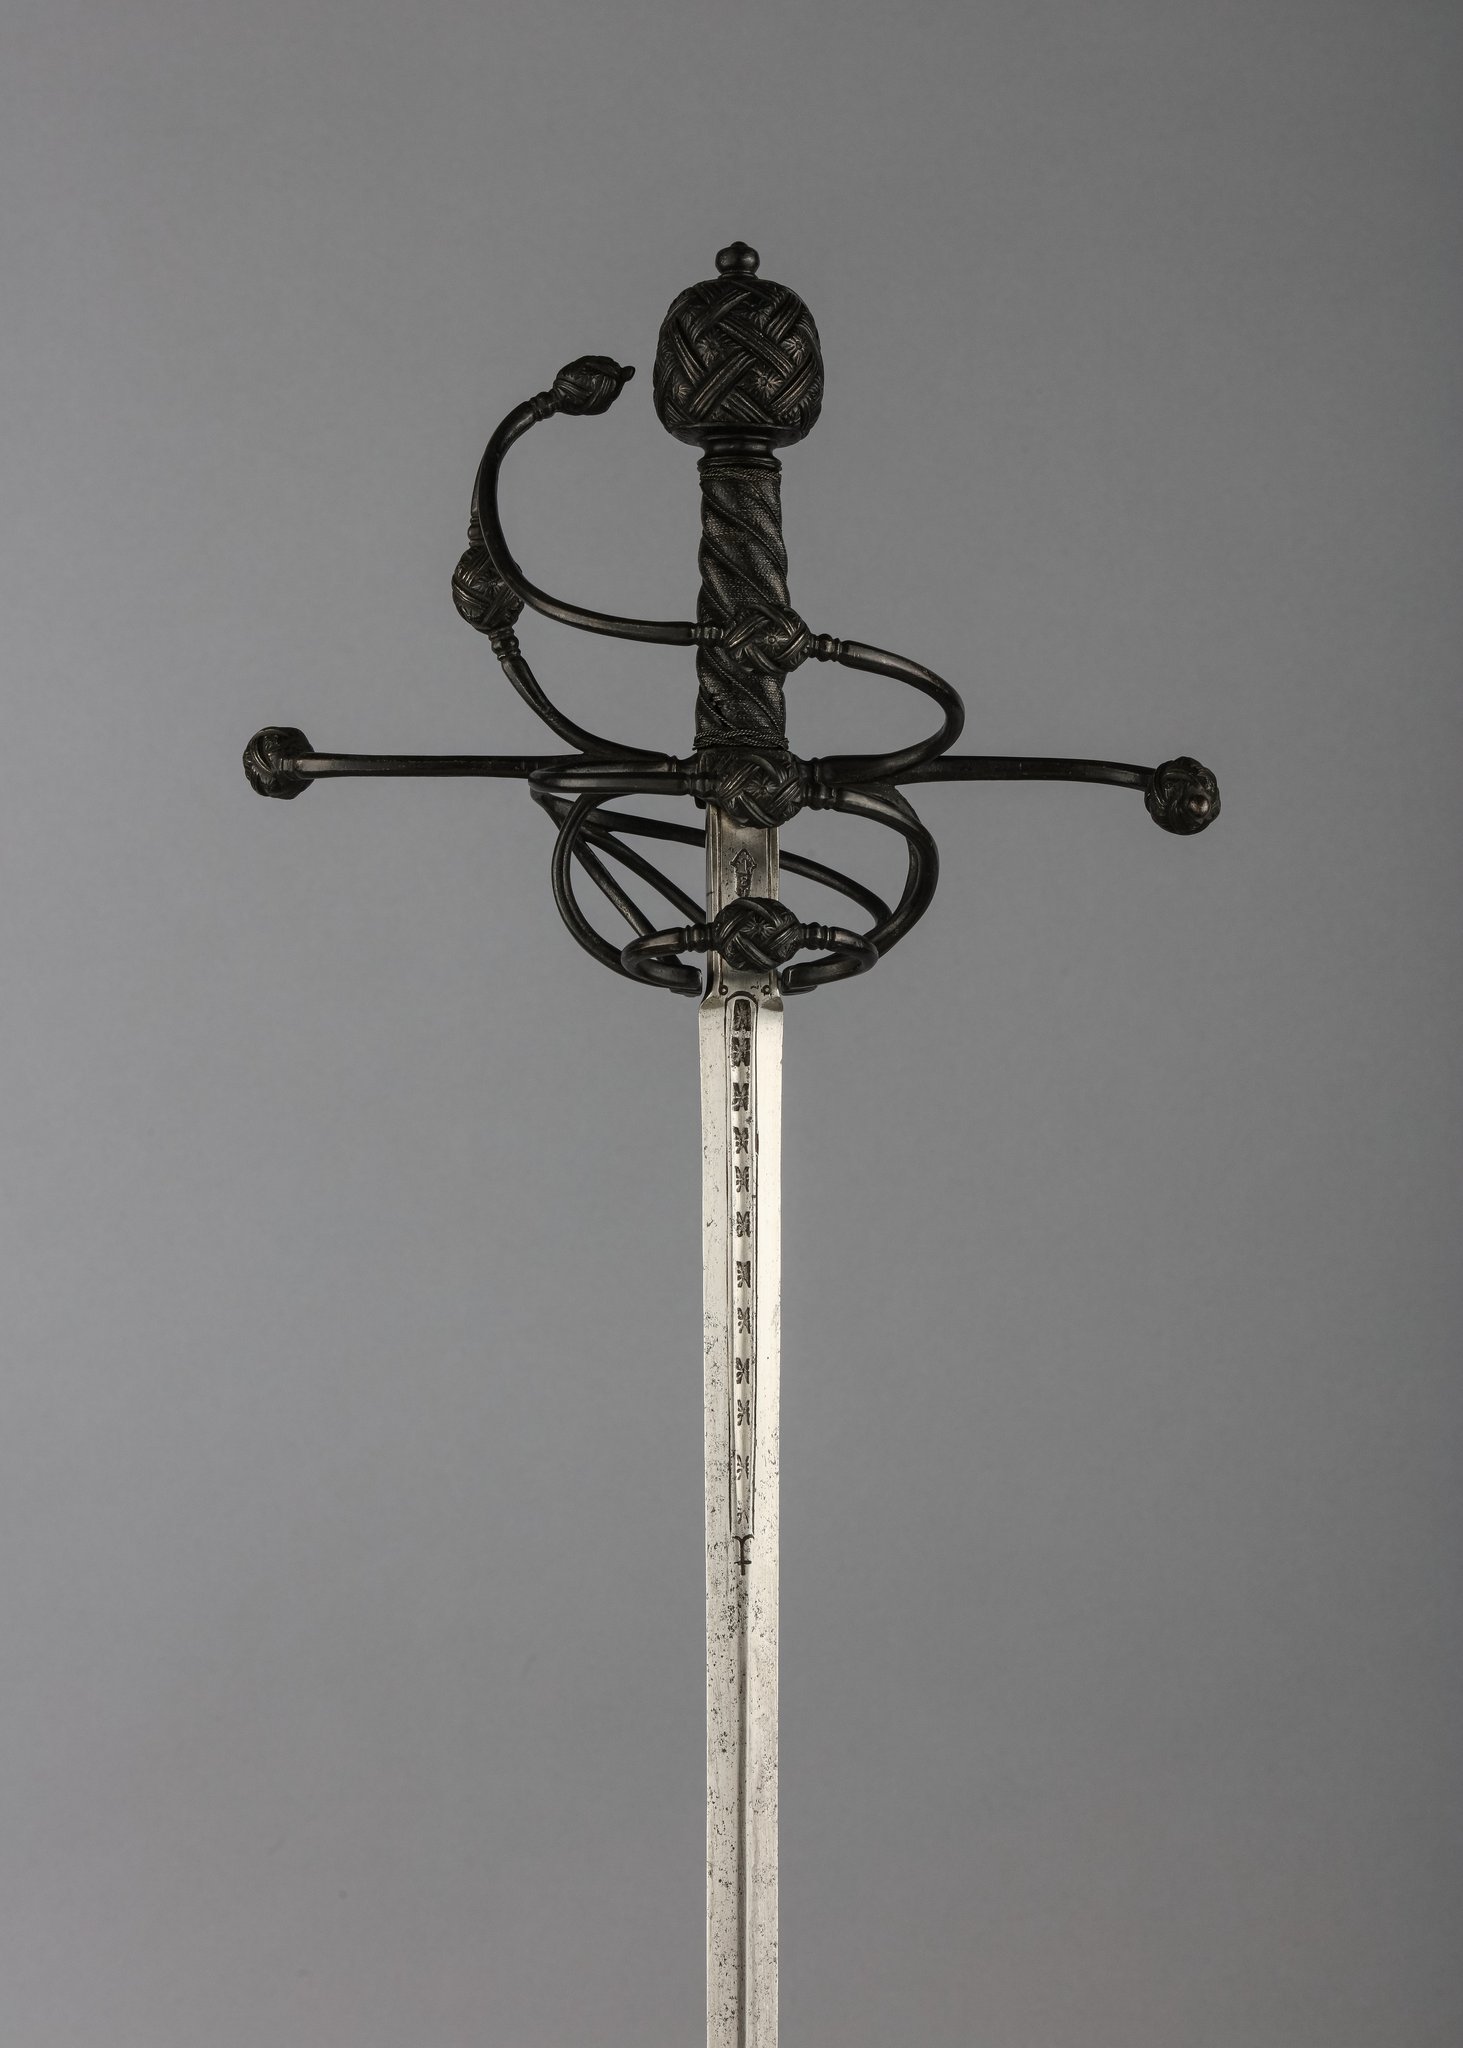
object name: rapier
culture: italian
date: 1565-1575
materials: steel, wood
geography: italy